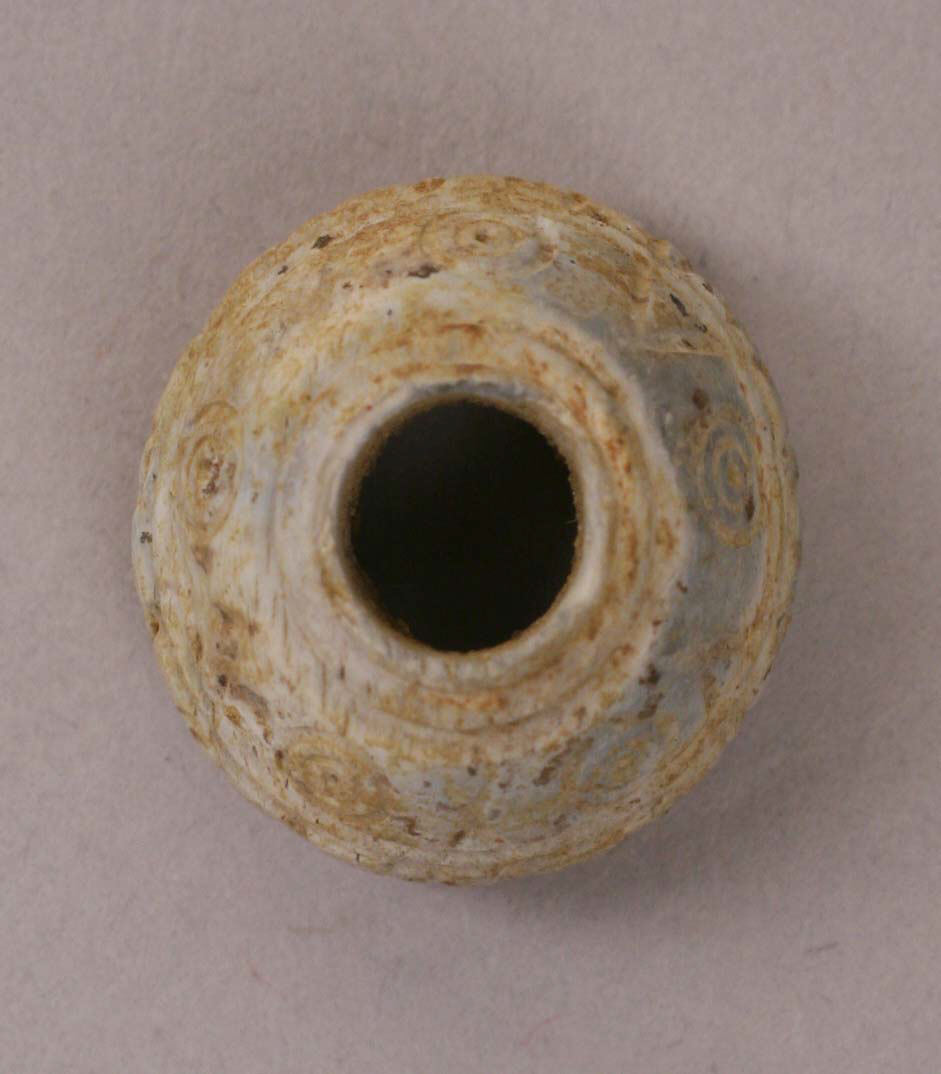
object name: button or bead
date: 801-1000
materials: bone, paint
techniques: incising, inlay, tinting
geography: iran